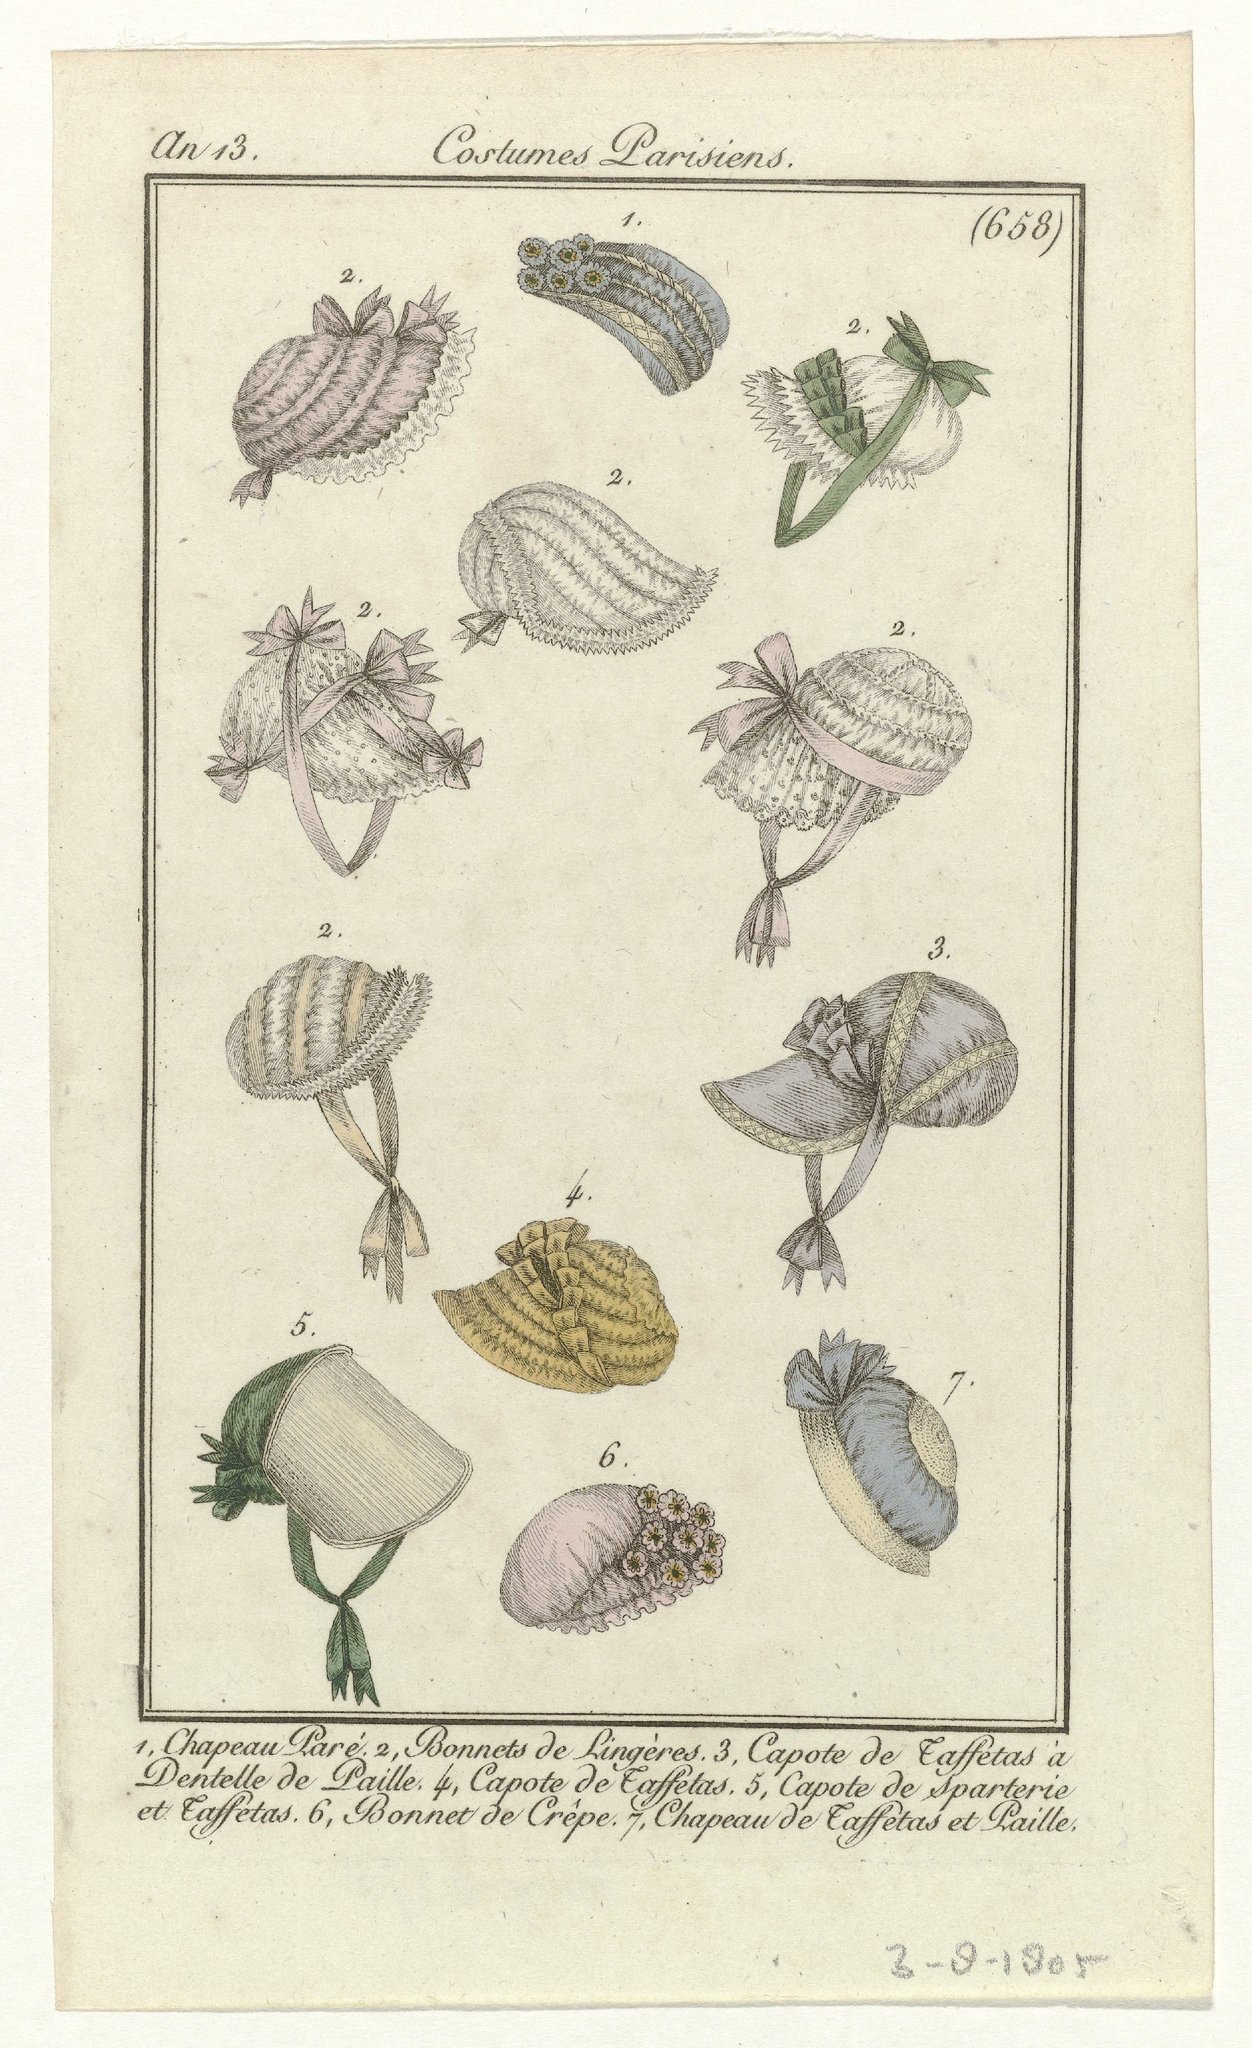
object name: fashion print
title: Journal des Dames et des Modes, Costumes Parisiens, 3 août 1805, An 13, (658): Chapeau Paré (...)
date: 1805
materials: paper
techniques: engraving, hand coloring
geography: paris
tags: head-gear (capote) (+ women's clothes), head-gear: cap (+ women's clothes), fashion plates, head-gear: hat (+ women's clothes)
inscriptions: caption: ‘1, Chapeau Paré. 2, Bonnets de Lingères. 3, Capote de Taffetas à Dentelle de Paille. 4, Capote de Taffetas. 5, Capote de Sparterie et taffetas. 6, Bonnet de Crêpe. 7, Chapeau de Taffetas et Paille.’, title: ‘Costumes Parisiens.’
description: Twaalf afbeeldingen van zeven typen hoofddeksels, genummerd één tot en met zeven. 1, 'Chapeau paré'. 2, 'Bonnets de lingères'. 3, Capote van tafzijde 'à dentelle de paille'. 4, Capote van tafzijde. 5, Capote van 'sparterie' (gevlochten plantenvezels) en tafzijde. 6, Muts van crêpe. 7, Hoed van tafzijde en stro. De prent maakt deel uit van het modetijdschrift Journal des Dames et des Modes, uitgegeven door Pierre de la Mésangère, Parijs, 1797-1839.